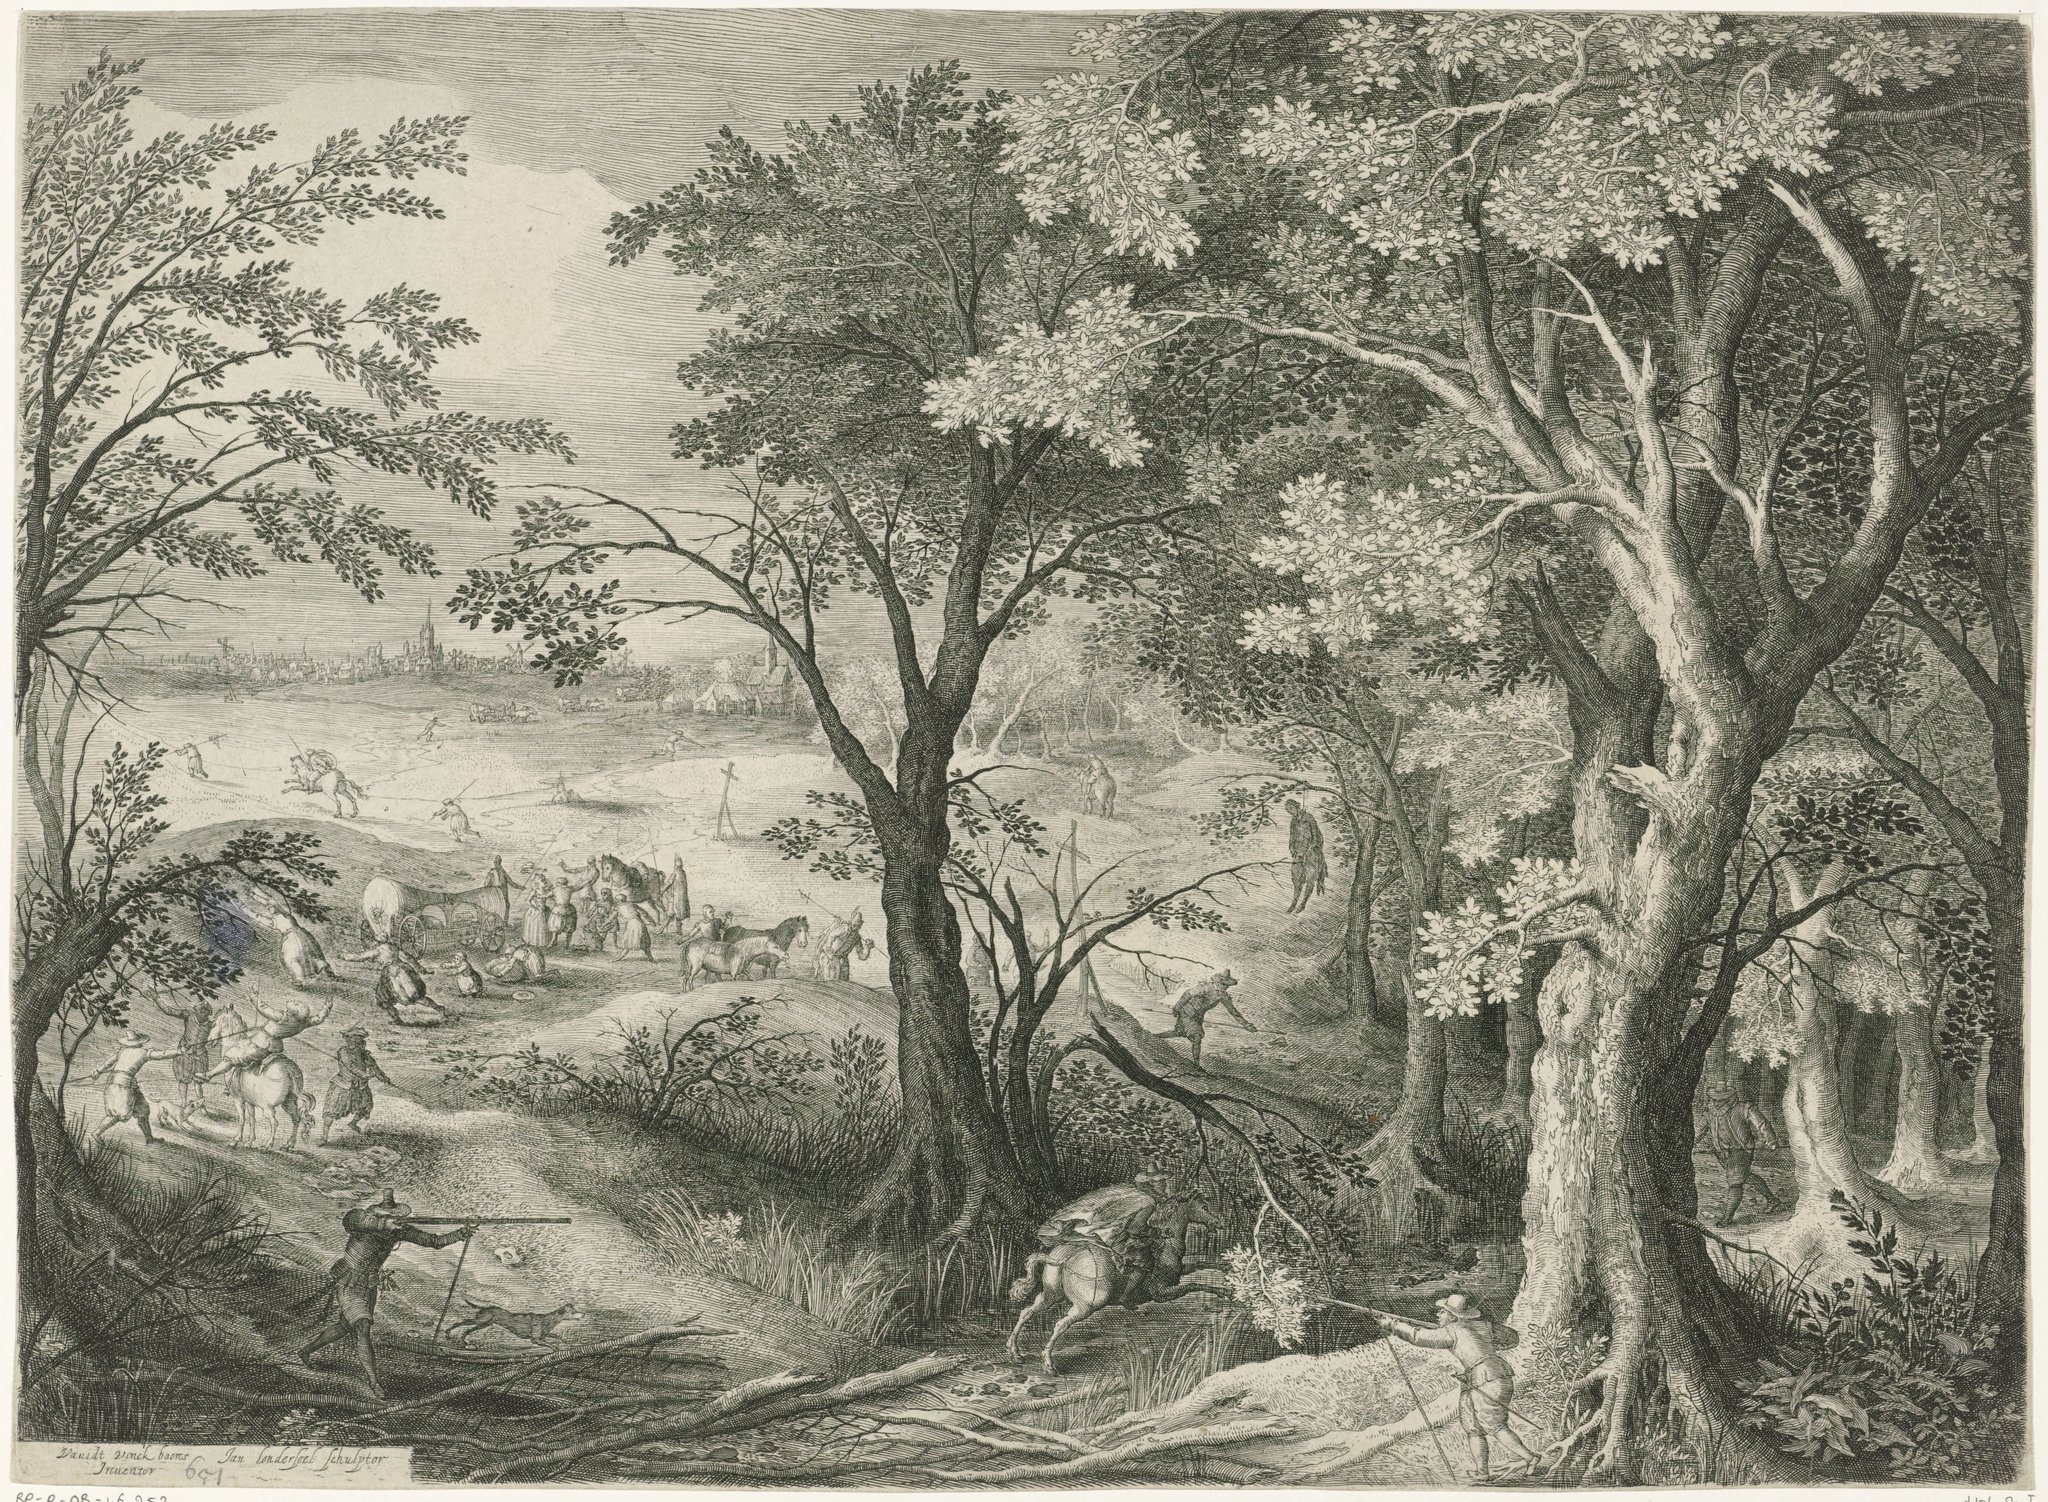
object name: print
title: Struikrovers overvallen reizigers in een landschap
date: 1580-1625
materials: paper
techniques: engraving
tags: traveller(s) attacked by robber(s), forest, wood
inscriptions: collector's mark: Lugt 240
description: Een bende struikrovers overvalt reizigers in een bosrijk landschap. De rovers doorzoeken het rijtuig terwijl de reizigers worden aangevallen en proberen te vluchten. Op de voorgrond wordt een ruiter door twee mannen beschoten. Links vallen drie mannen met speren een tweede ruiter aan. Verder het bos in hangt een man aan een strop in een boom.